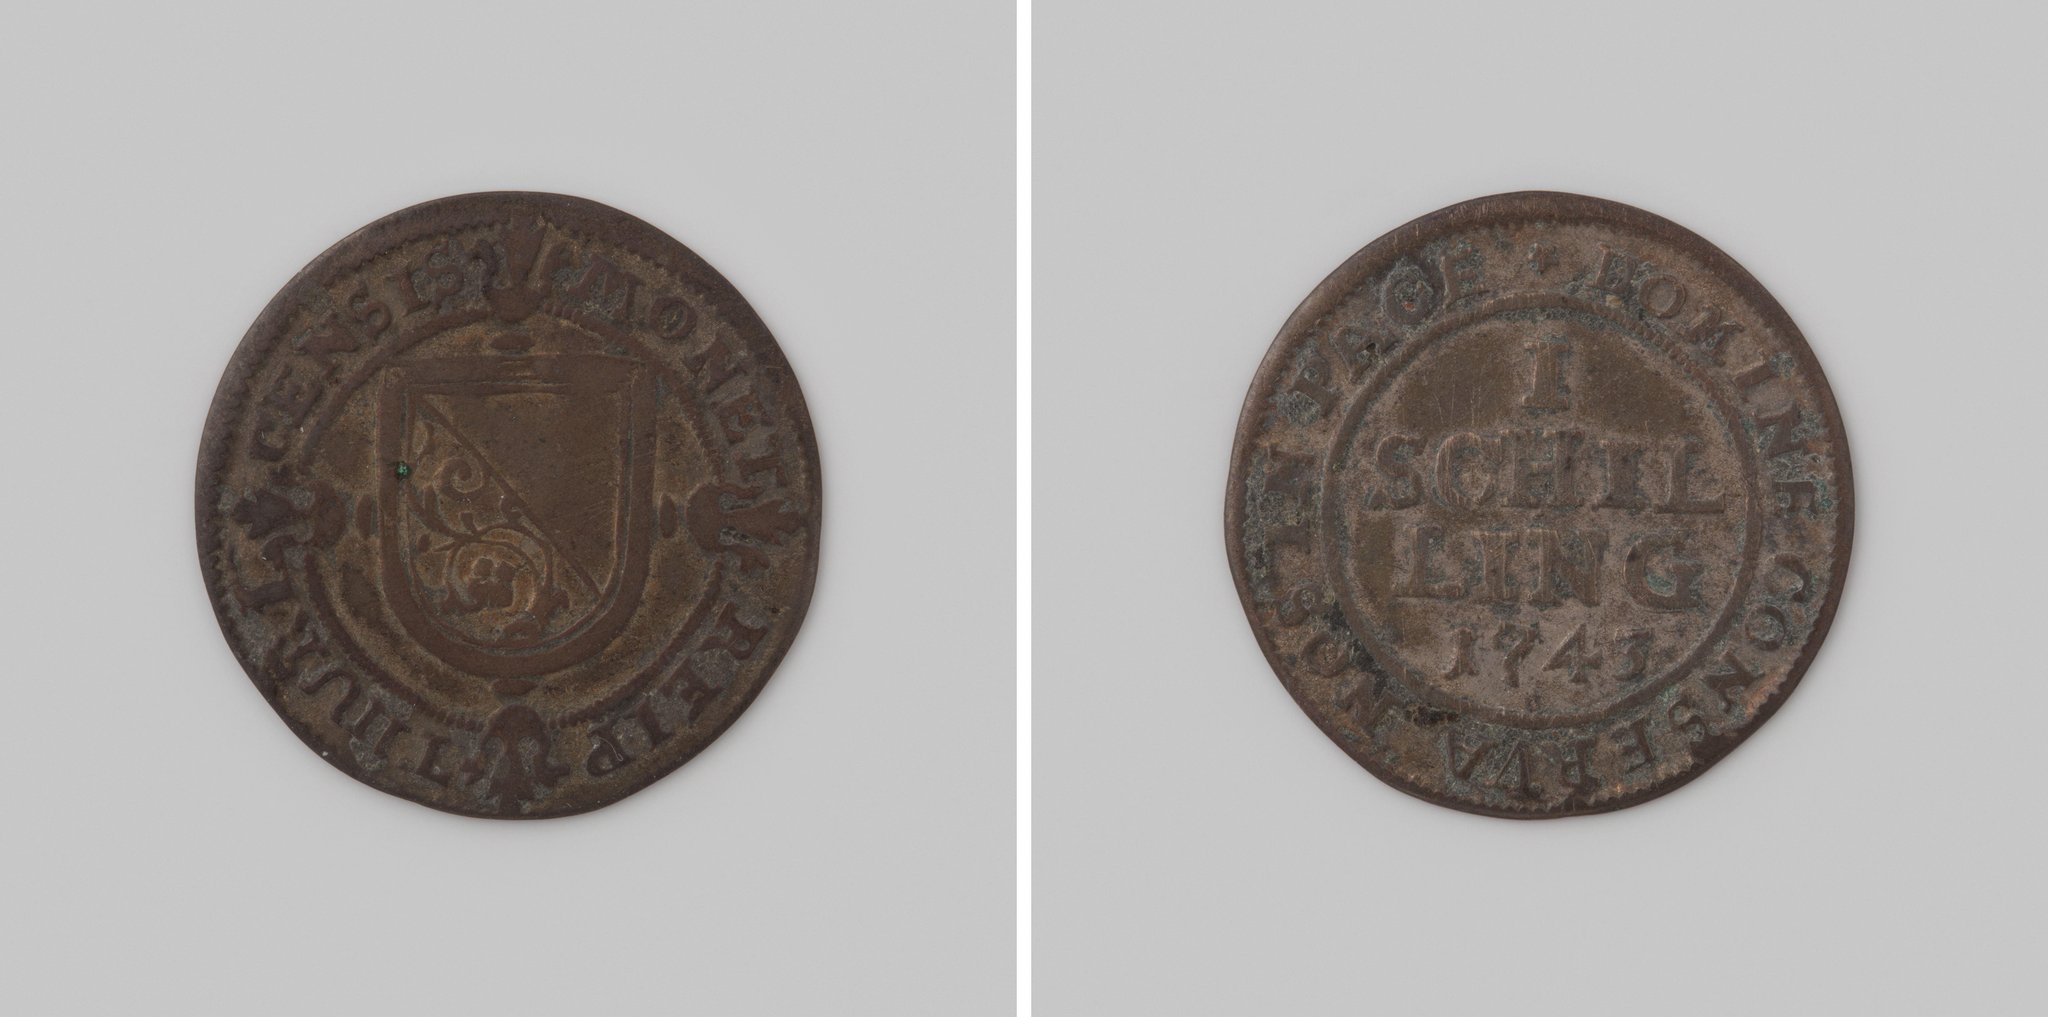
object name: coin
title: Schilling uit het kanton Zürich,1743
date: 1743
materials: silver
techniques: striking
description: Zilveren munt. Voorzijde: op lang gebloemd kruis wapenschild. Keerzijde: in drie regels waarde-aanduiding, waaronder jaartal. Gladde rand.